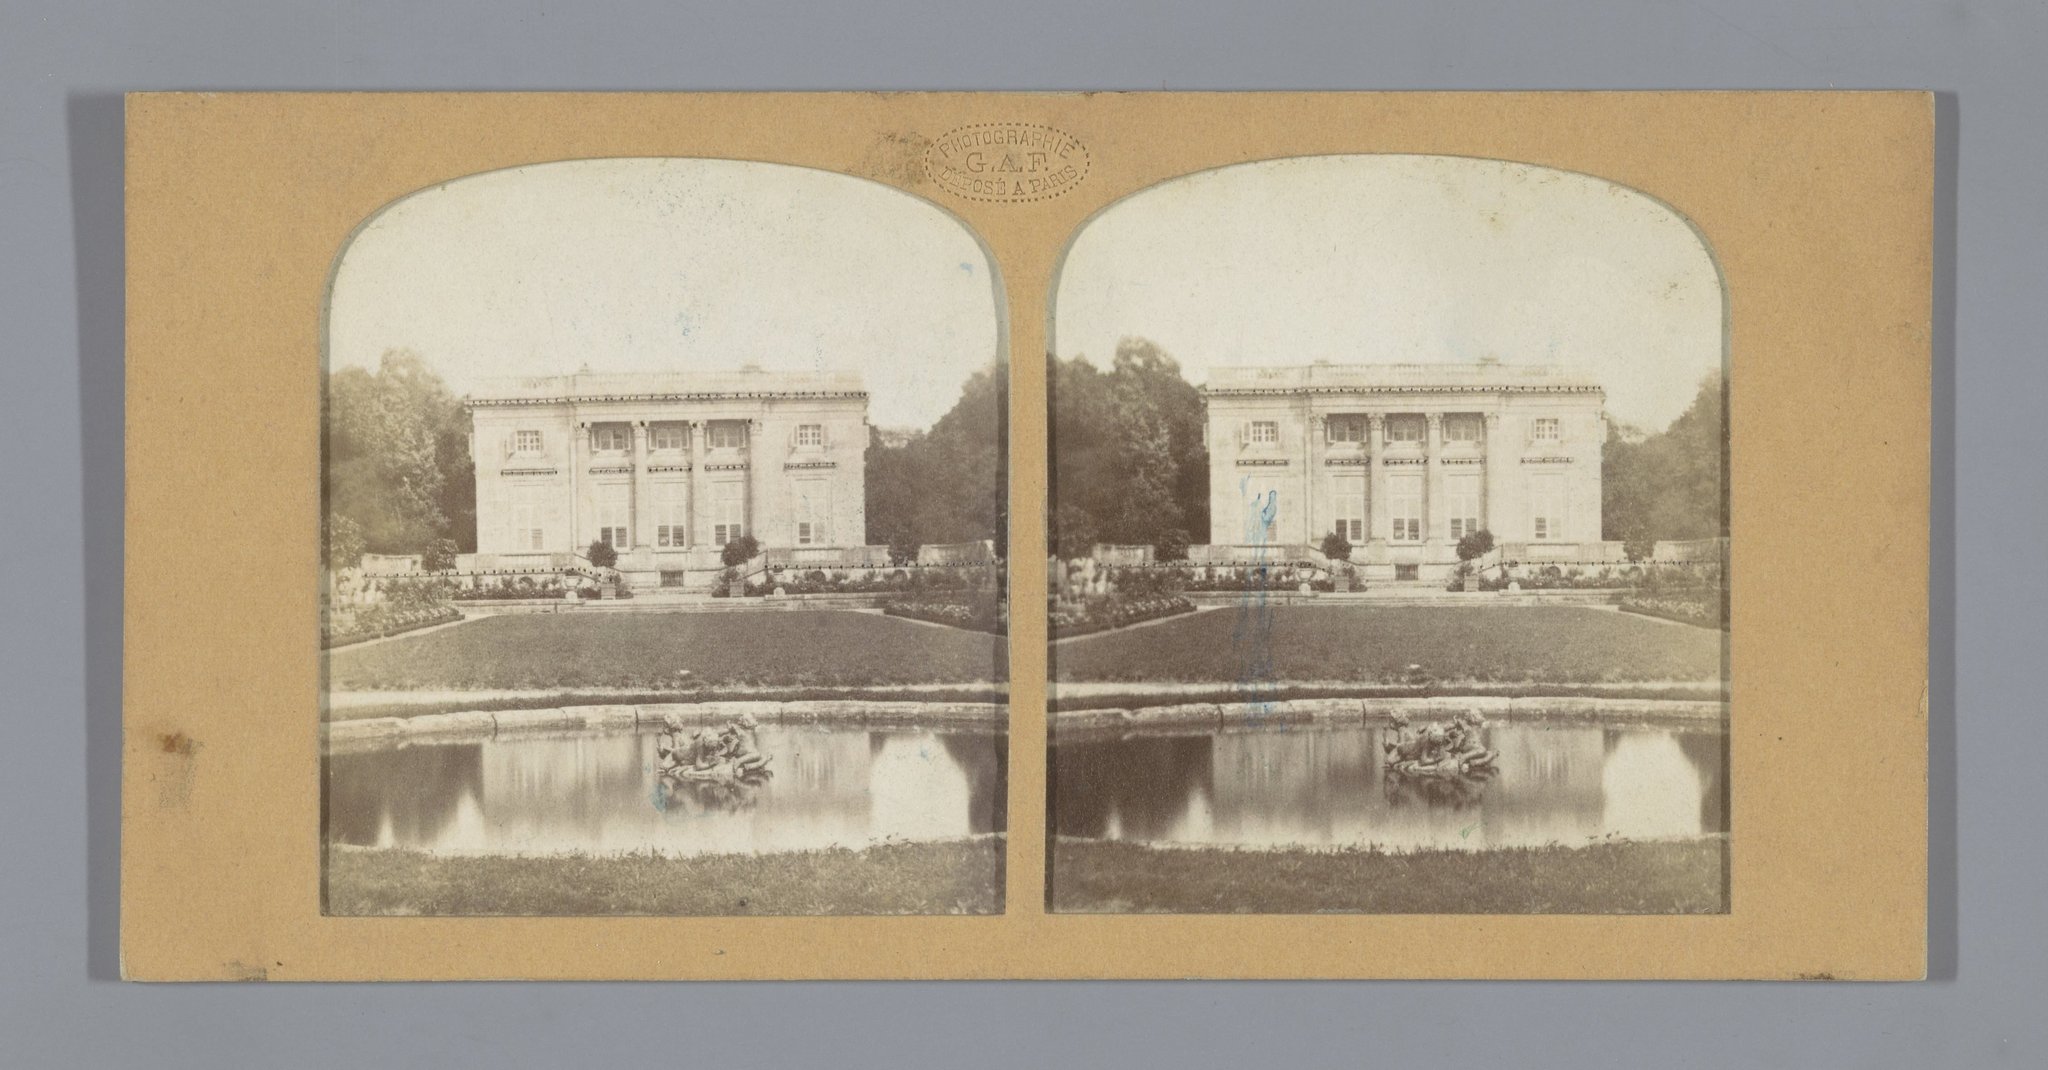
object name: tissue stereograph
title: Paris, Petit Trianon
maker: florent grau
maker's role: manufacturer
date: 1858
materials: cardboard, paper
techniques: albumen print, hand coloring, perforating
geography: versailles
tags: palace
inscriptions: inscription: ‘Déposé a Paris’